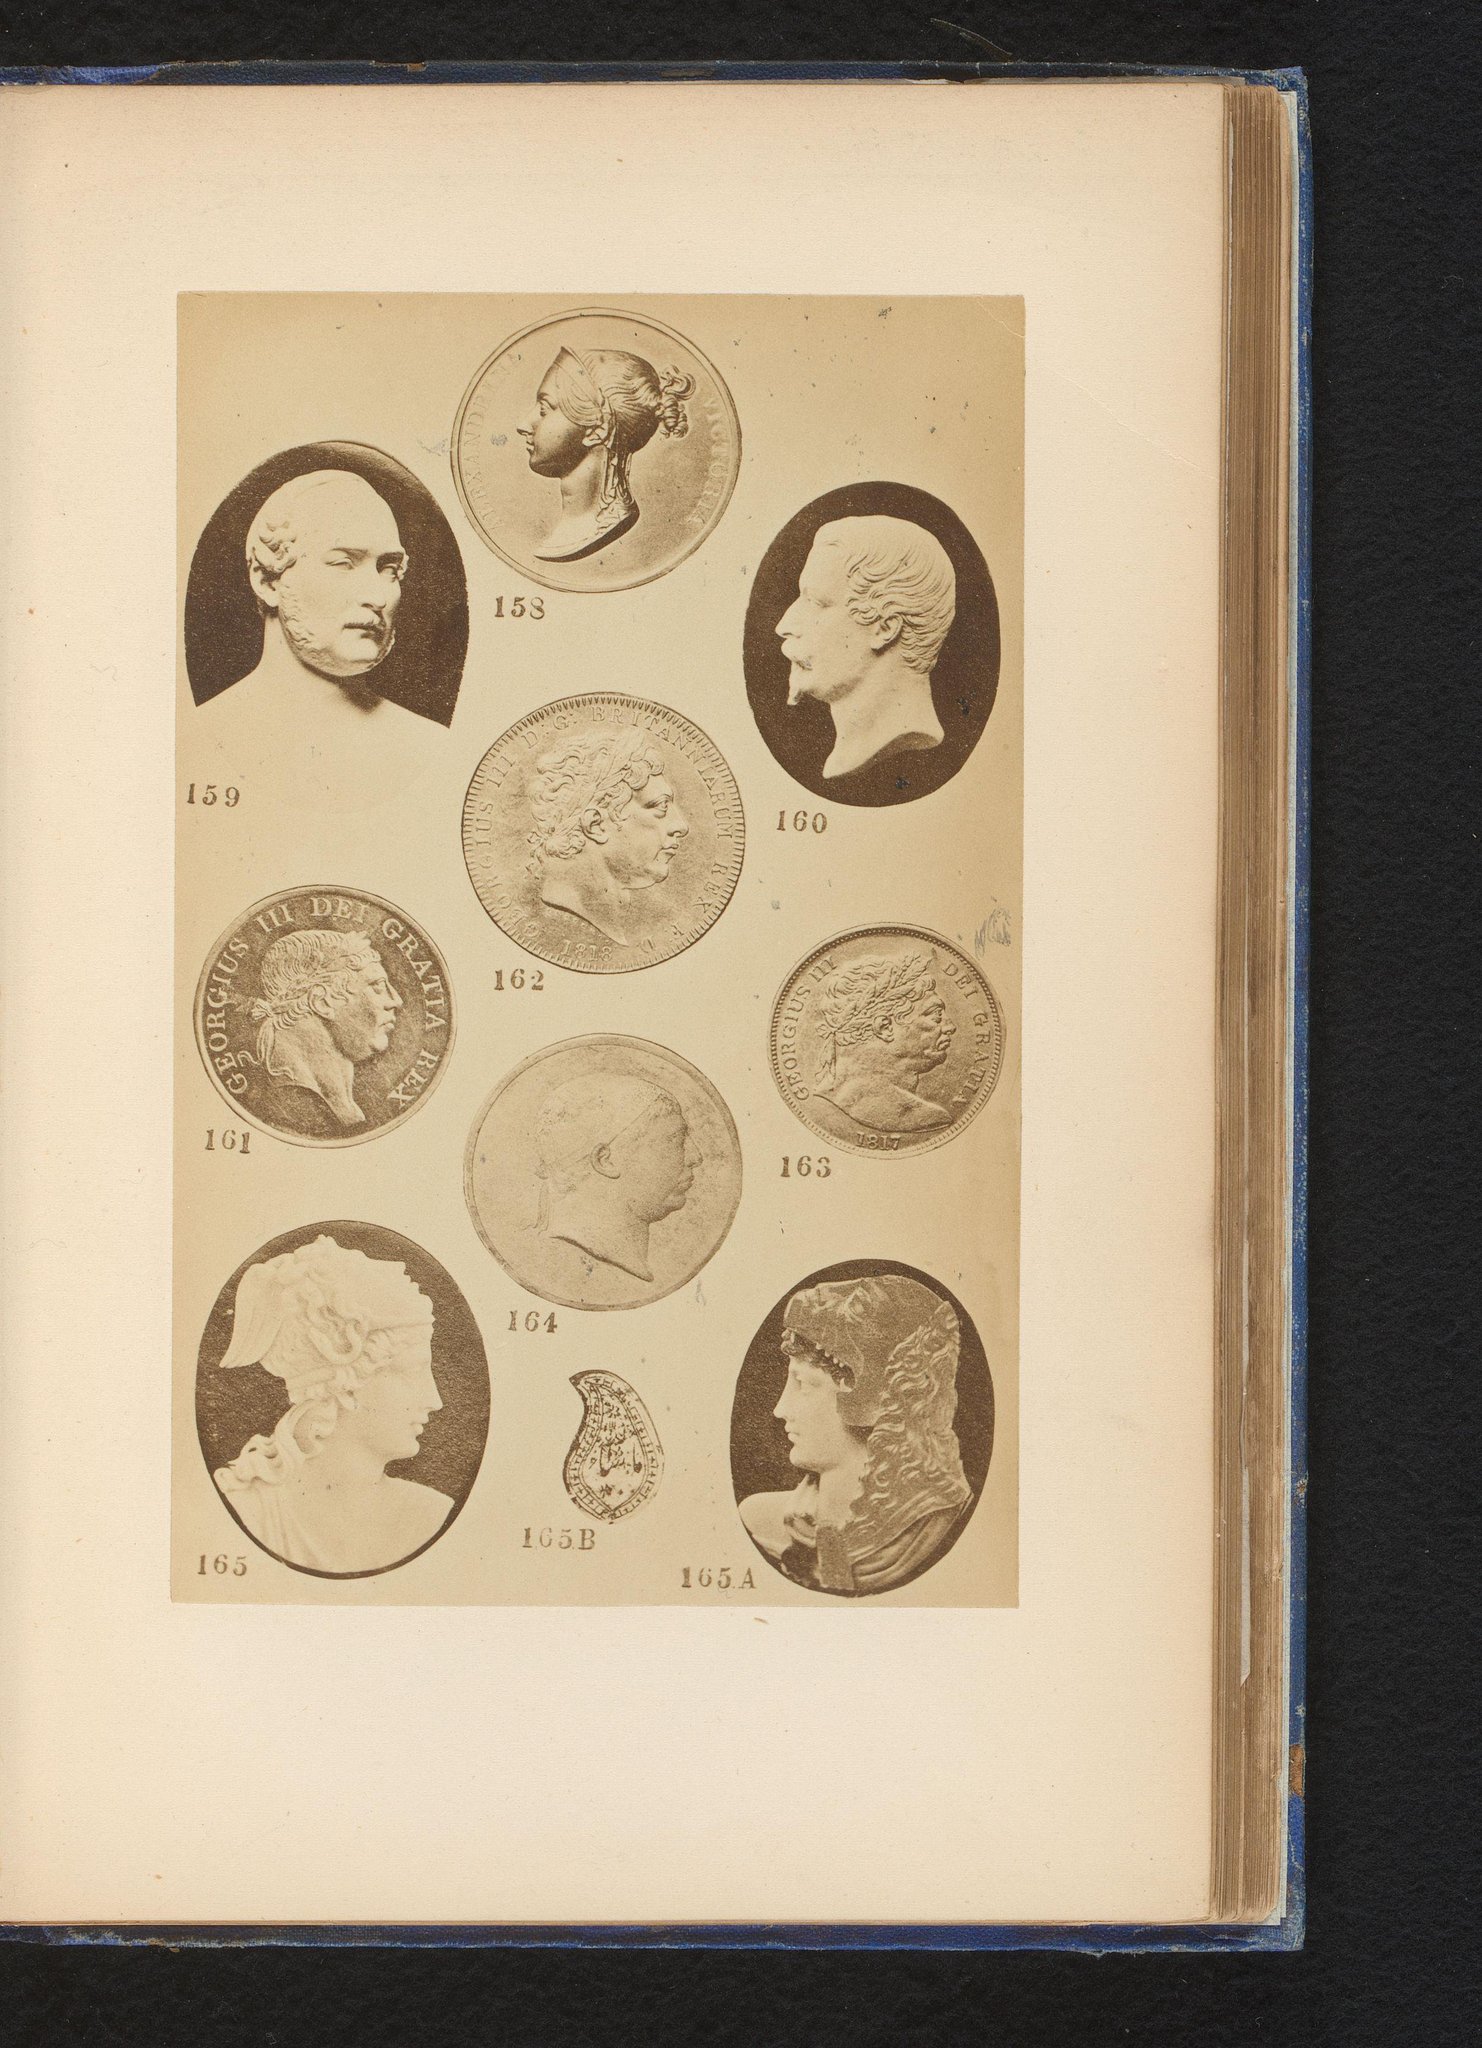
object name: page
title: Negen portretten in reliëf en een Turkse ring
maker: f. cole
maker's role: fotograaf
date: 1862-1867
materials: paper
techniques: albumen print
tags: ring, sculpture (+ relief ~ sculpture)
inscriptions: number: ‘158 - 165A’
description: Foto op derde ongenummerde pagina na pagina 148.